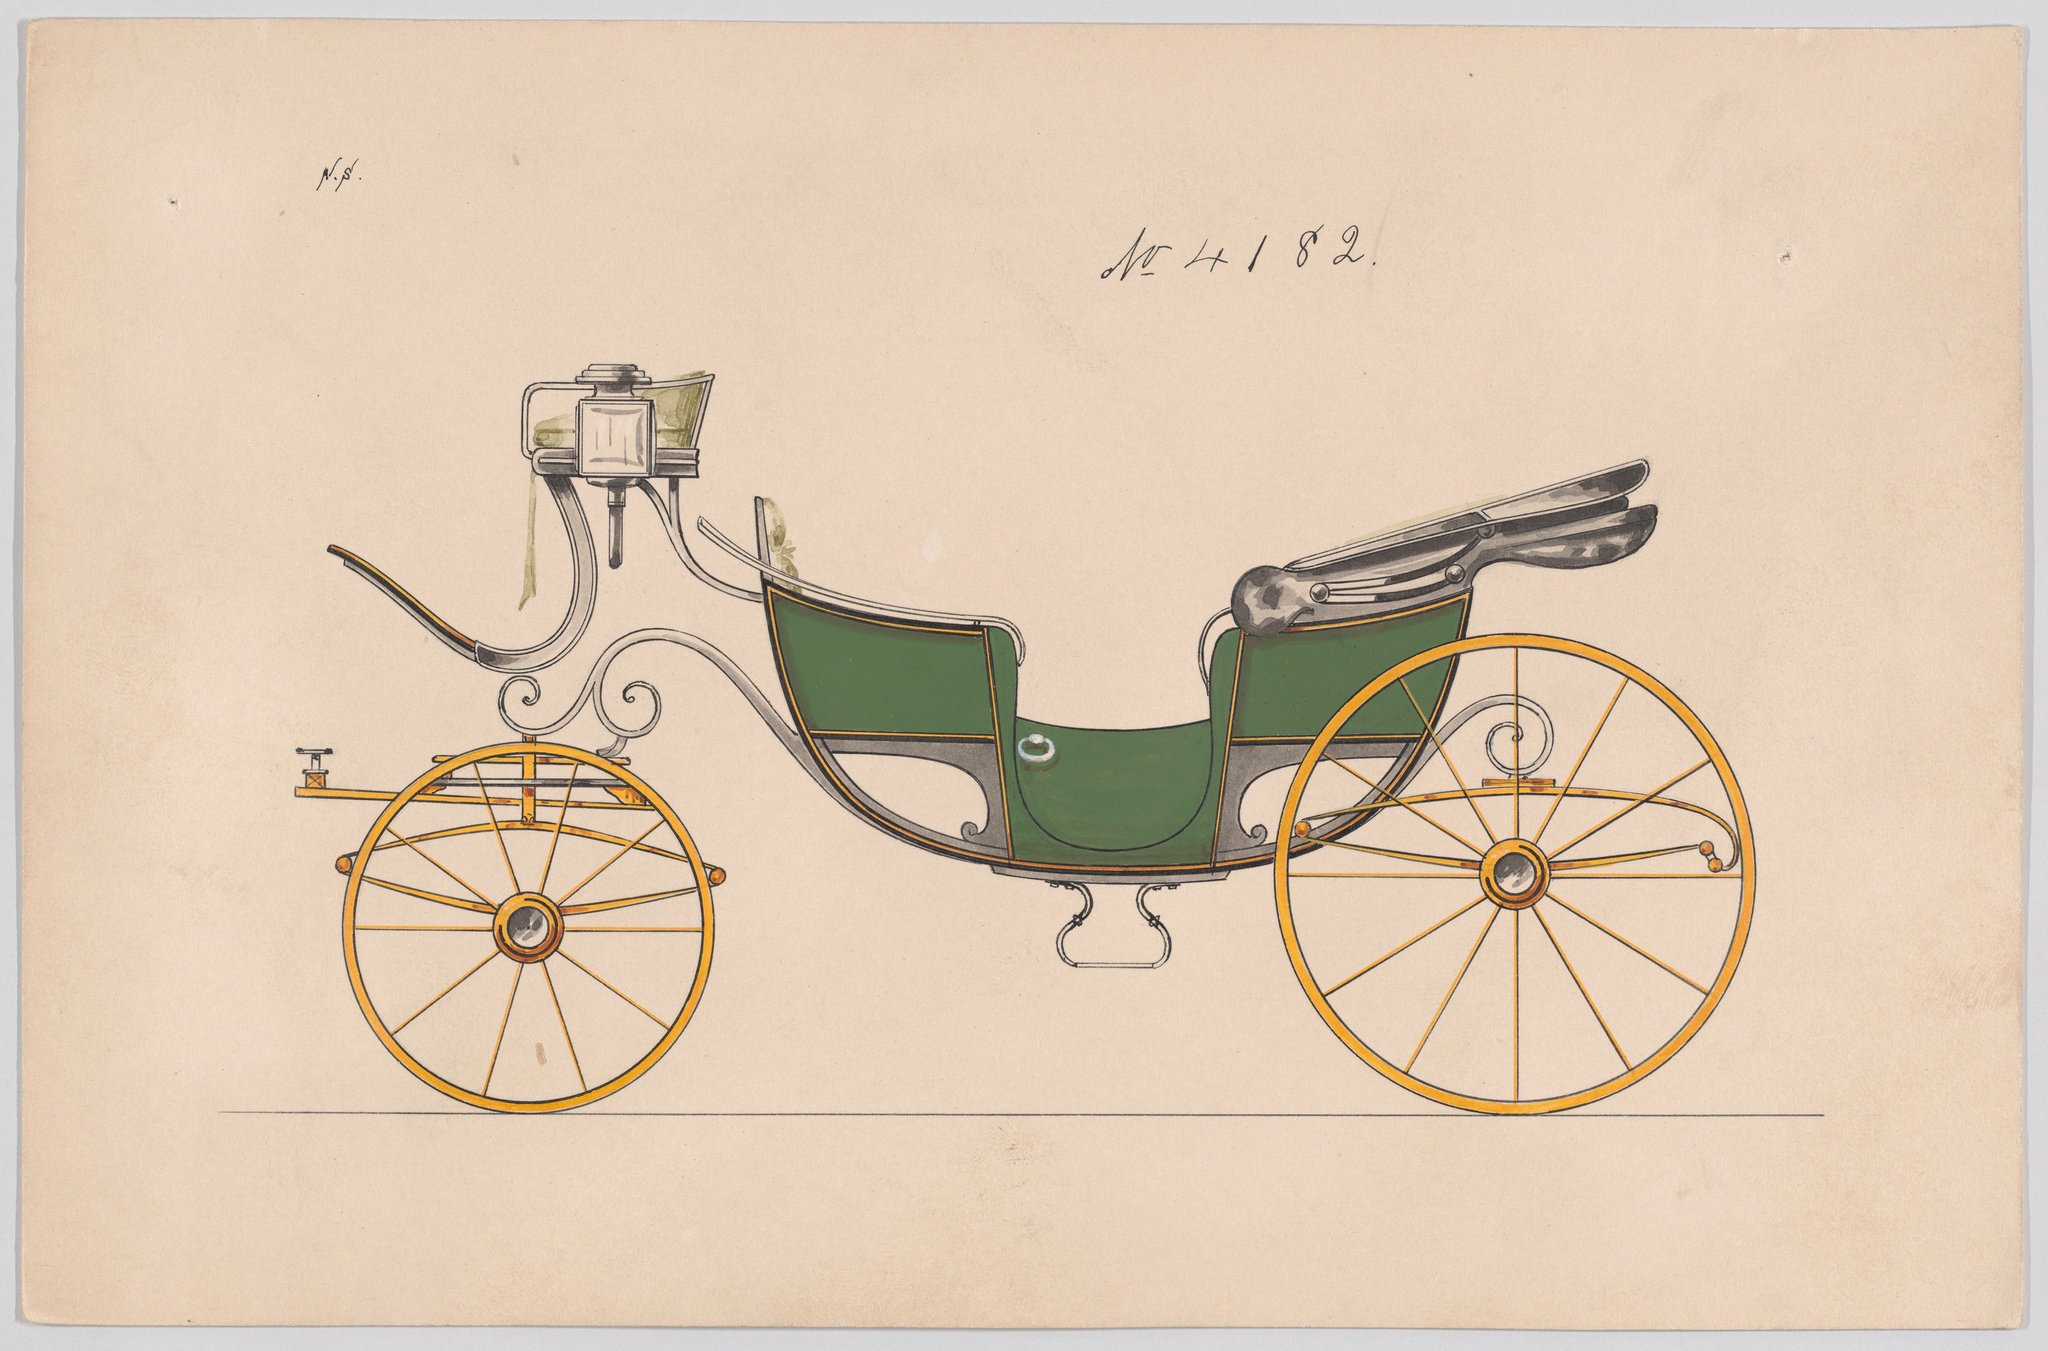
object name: drawing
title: Vis-à-vis #4182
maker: brewster & co.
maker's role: manufacturer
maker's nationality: american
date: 1892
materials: gouache, ink, watercolor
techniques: pen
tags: carriages